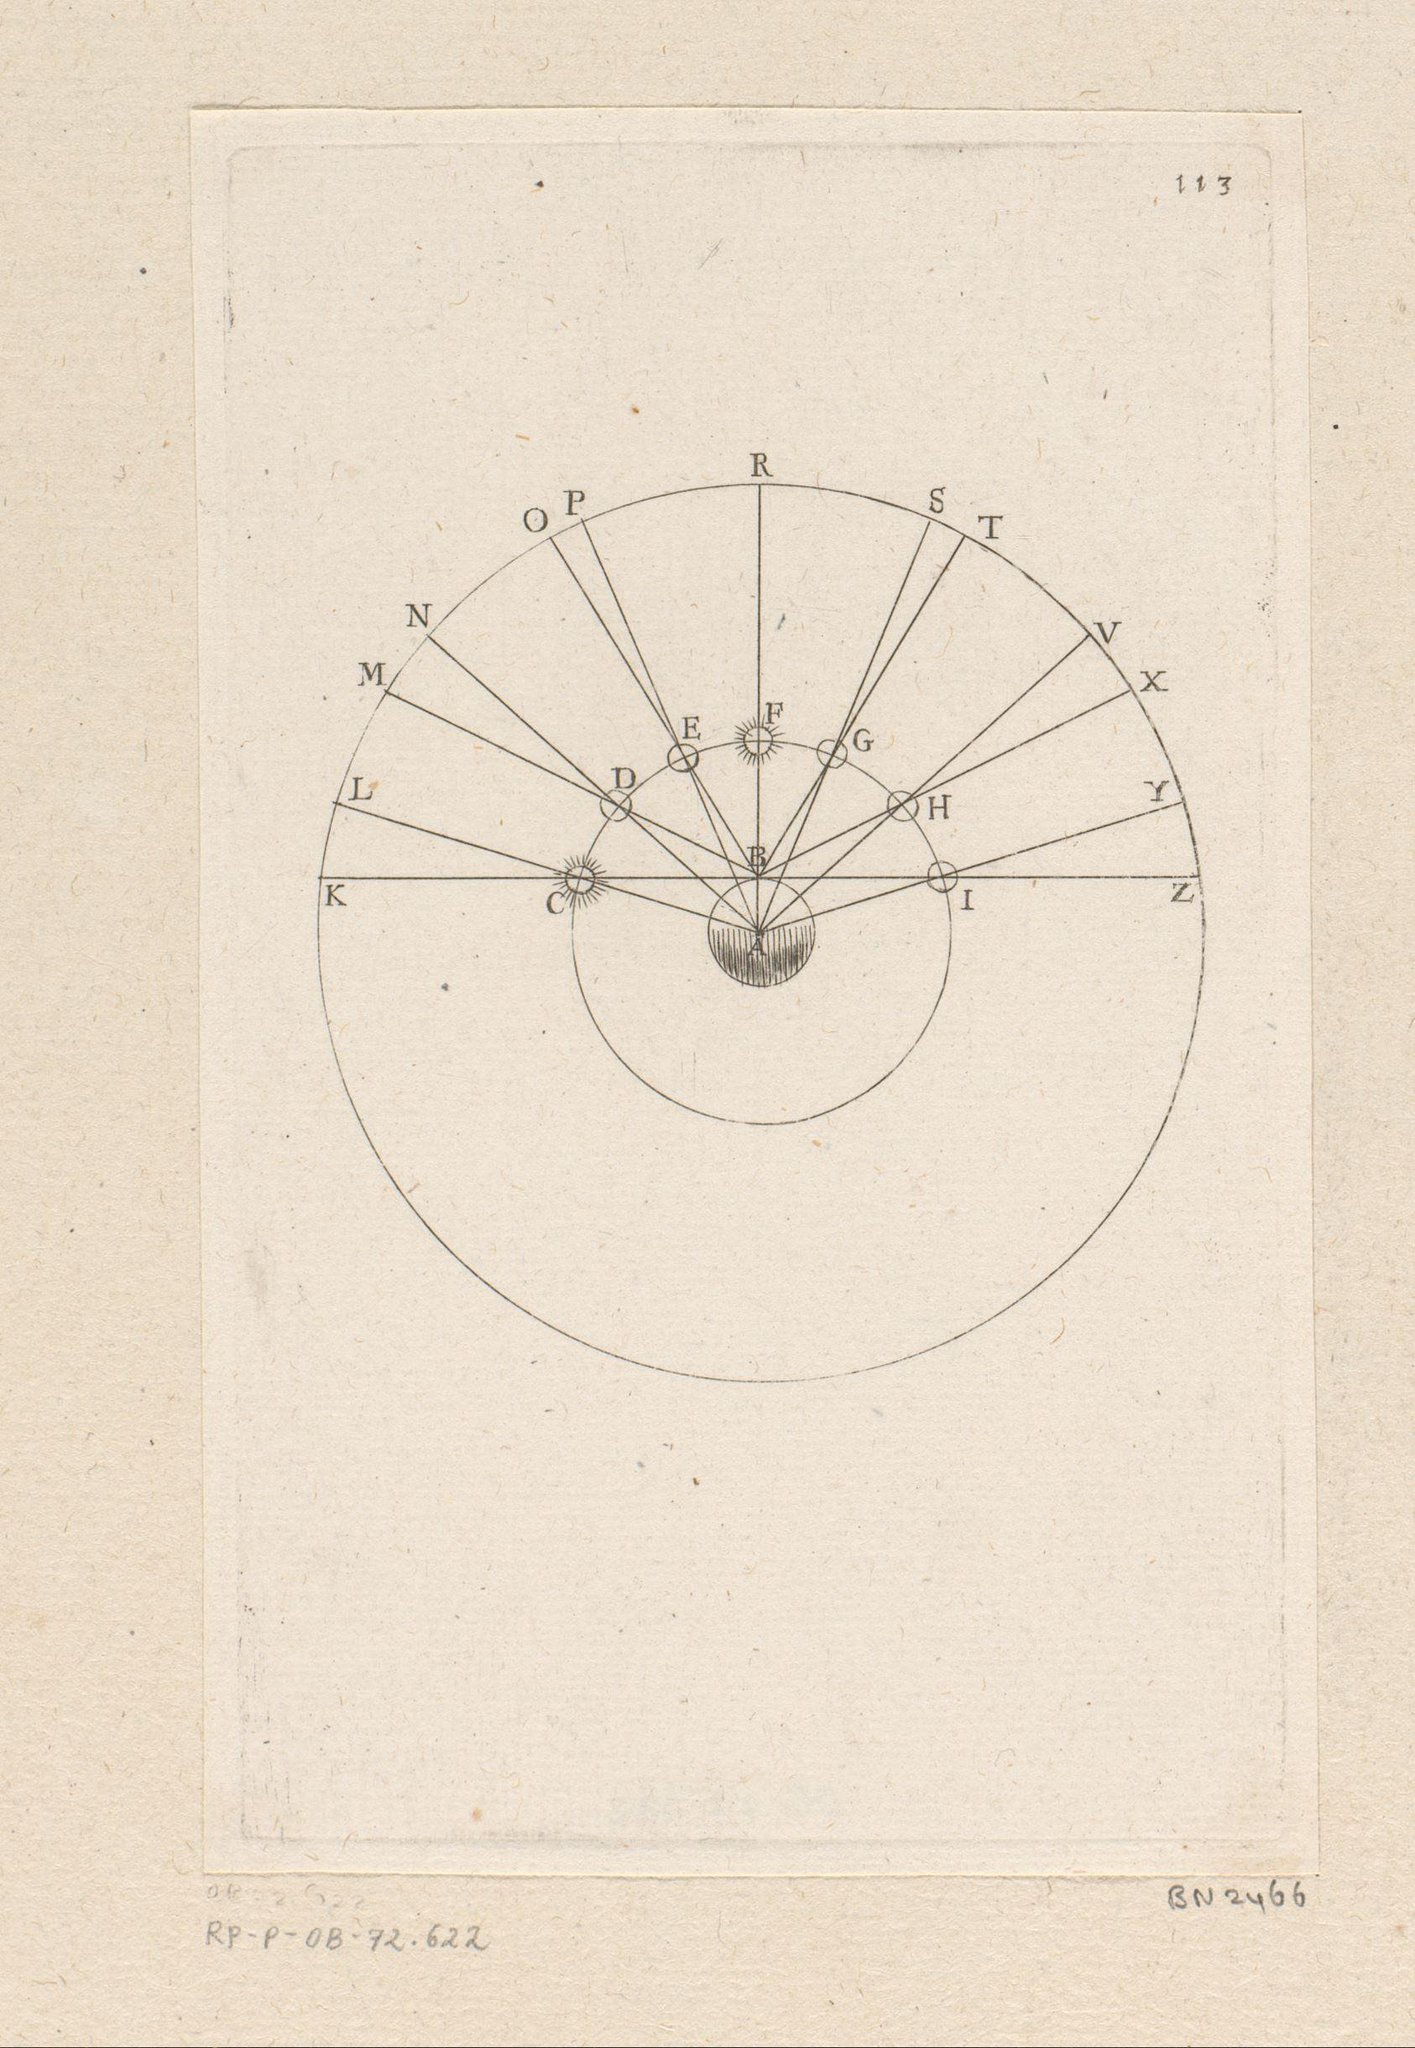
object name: book illustration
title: Positie van de Zon ten opzichte van de dierenriem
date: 1706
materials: paper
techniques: etching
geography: france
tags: sun as celestial body, zodiac; the twelve zodiacal signs together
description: Prent uit: Leclerc, Sébastien. Nouveau systeme du monde conforme à l'Ecriture sainte. Où les phénomènes sont expliquez sans excentricité de mouvement (...). Paris: Pierre Giffart, 1706.